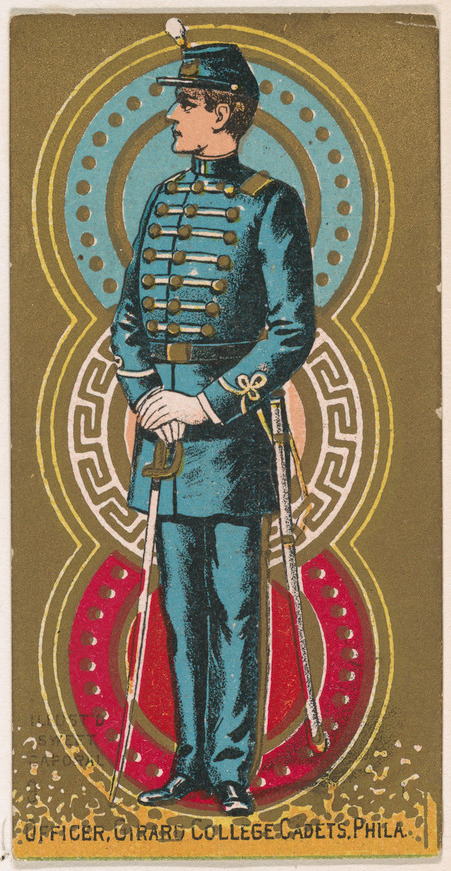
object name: print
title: Officer, Girard College Cadets, Philadelphia, from the Military Series (N224) issued by Kinney Tobacco Company to promote Sweet Caporal Cigarettes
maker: kinney brothers tobacco company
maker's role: publisher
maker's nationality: american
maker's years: 1869-2011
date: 1888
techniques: color lithograph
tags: military,men,profiles